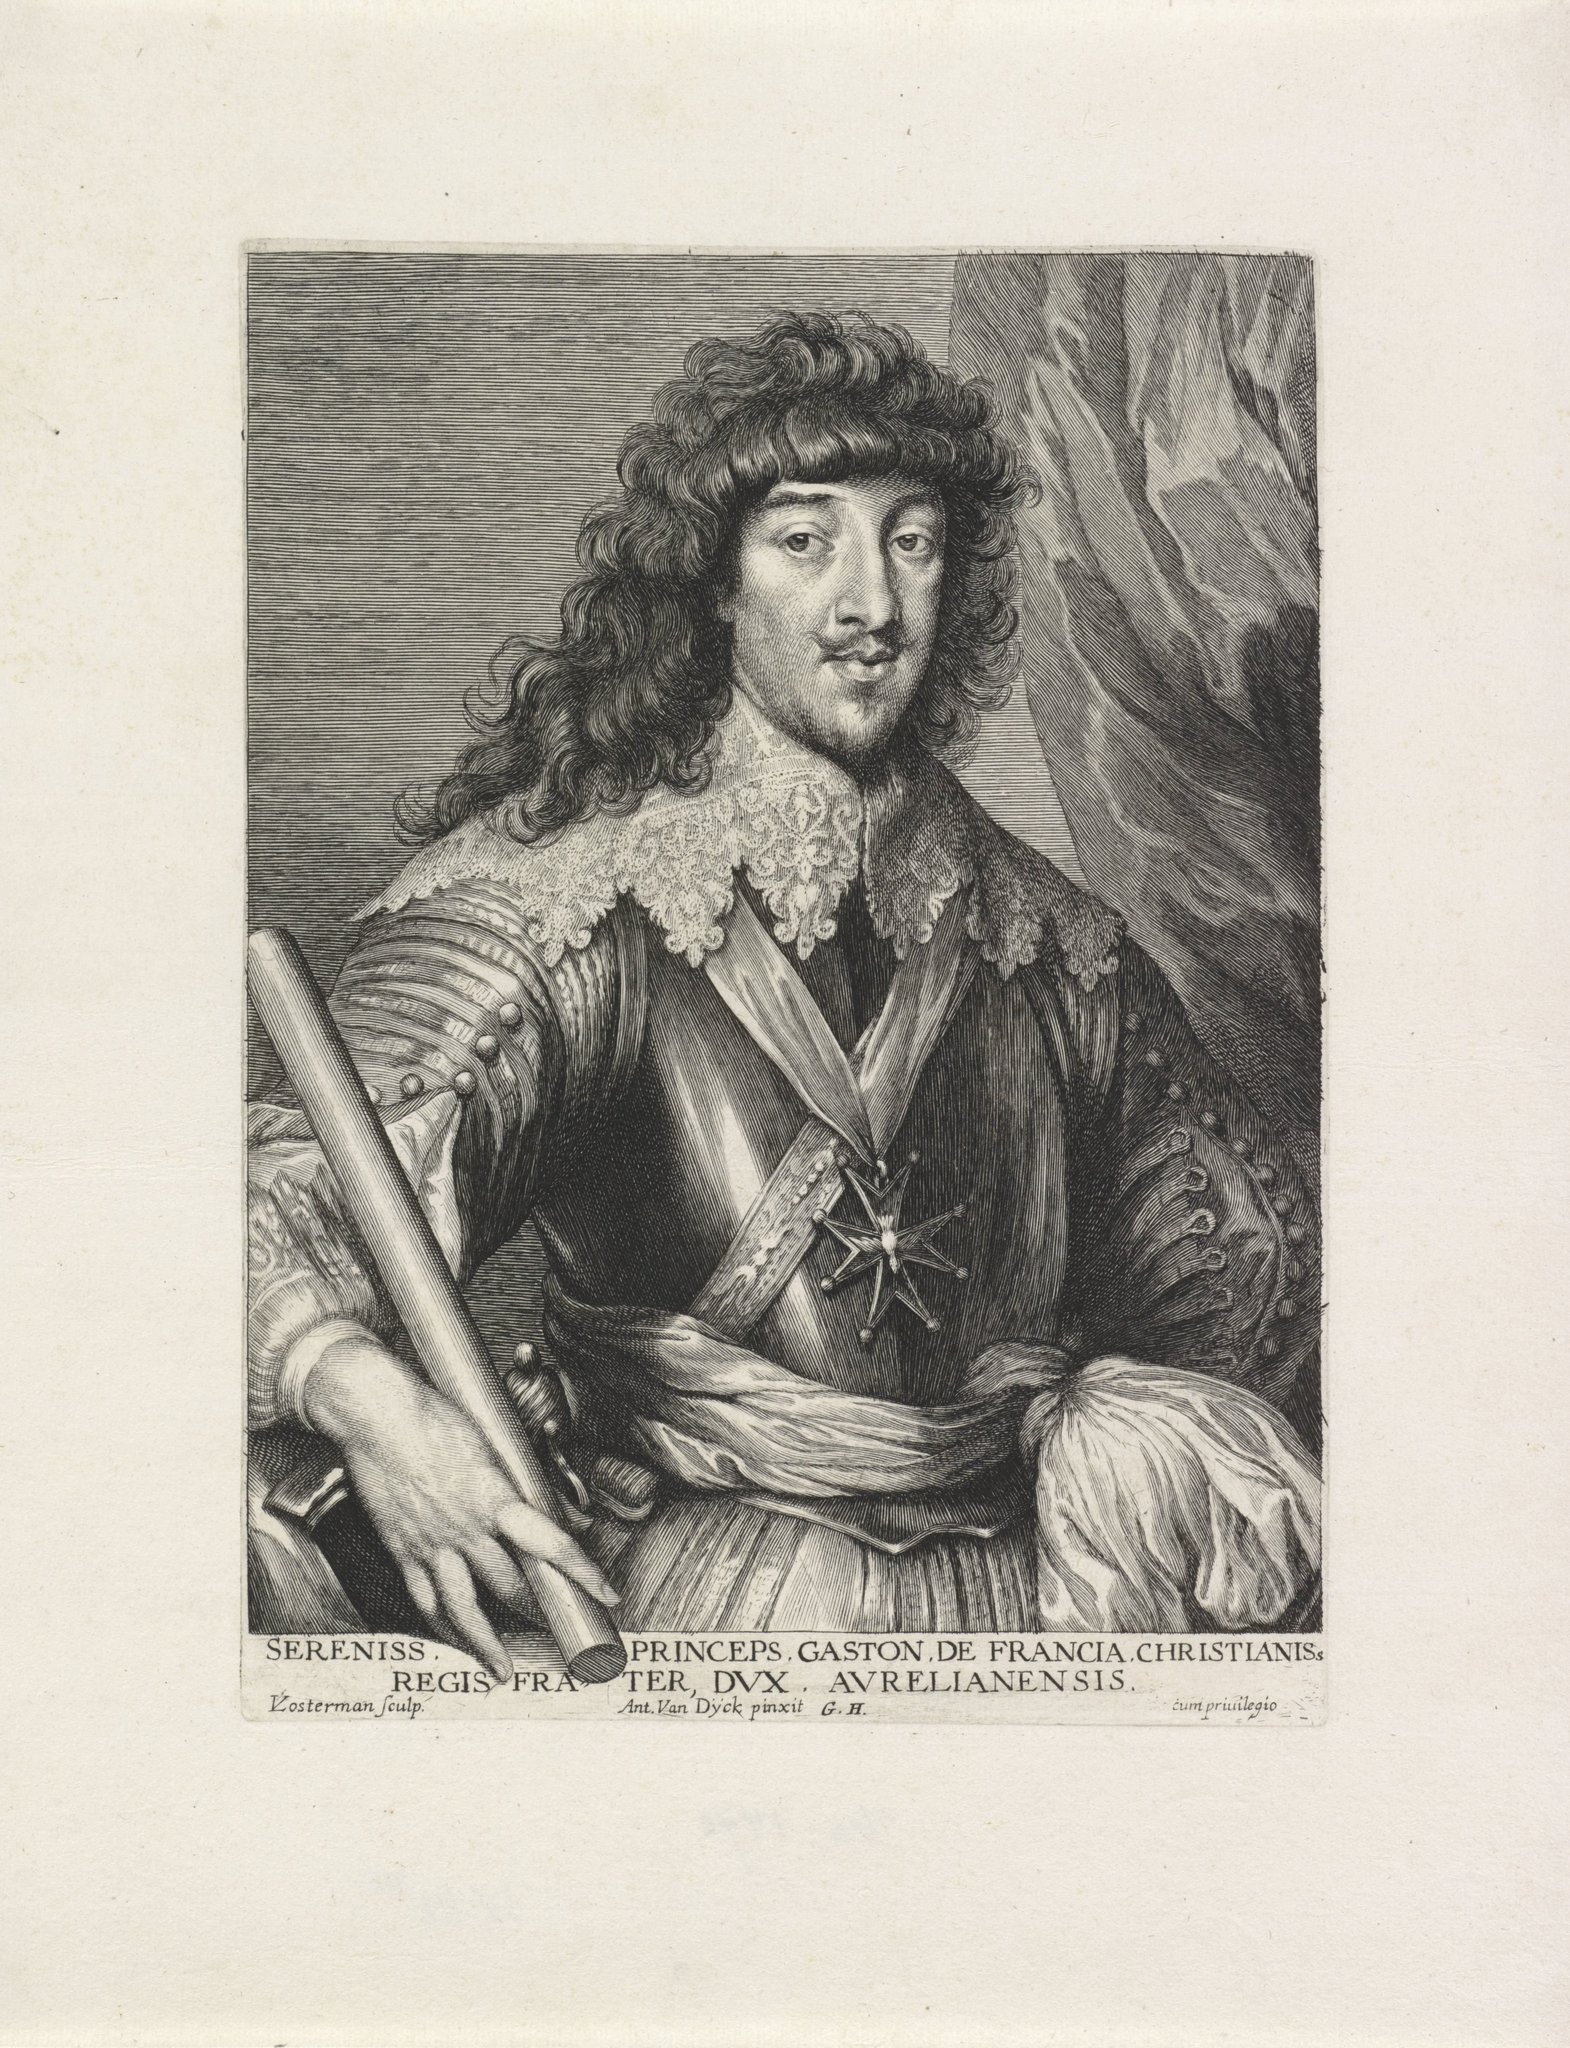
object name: print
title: Iconographie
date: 1645-1646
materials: paper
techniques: engraving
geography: antwerp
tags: gaston jean-baptiste hertog van orléans, baton of general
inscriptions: collector's mark: Lugt 2228, collector's mark: Lugt 2166, collector's mark: Lugt 2760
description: Prent gebruikt voor: Icones principum, virorum doctorum, pictorum, chalcographorum, statuariorum nec non amatorum pictoriae artis numero centum ab Ant. van Dyck ad vivum expressae ejusque sumptibus aeri incisae. Antwerpen: Gillis Hendricx, [1645-1646].